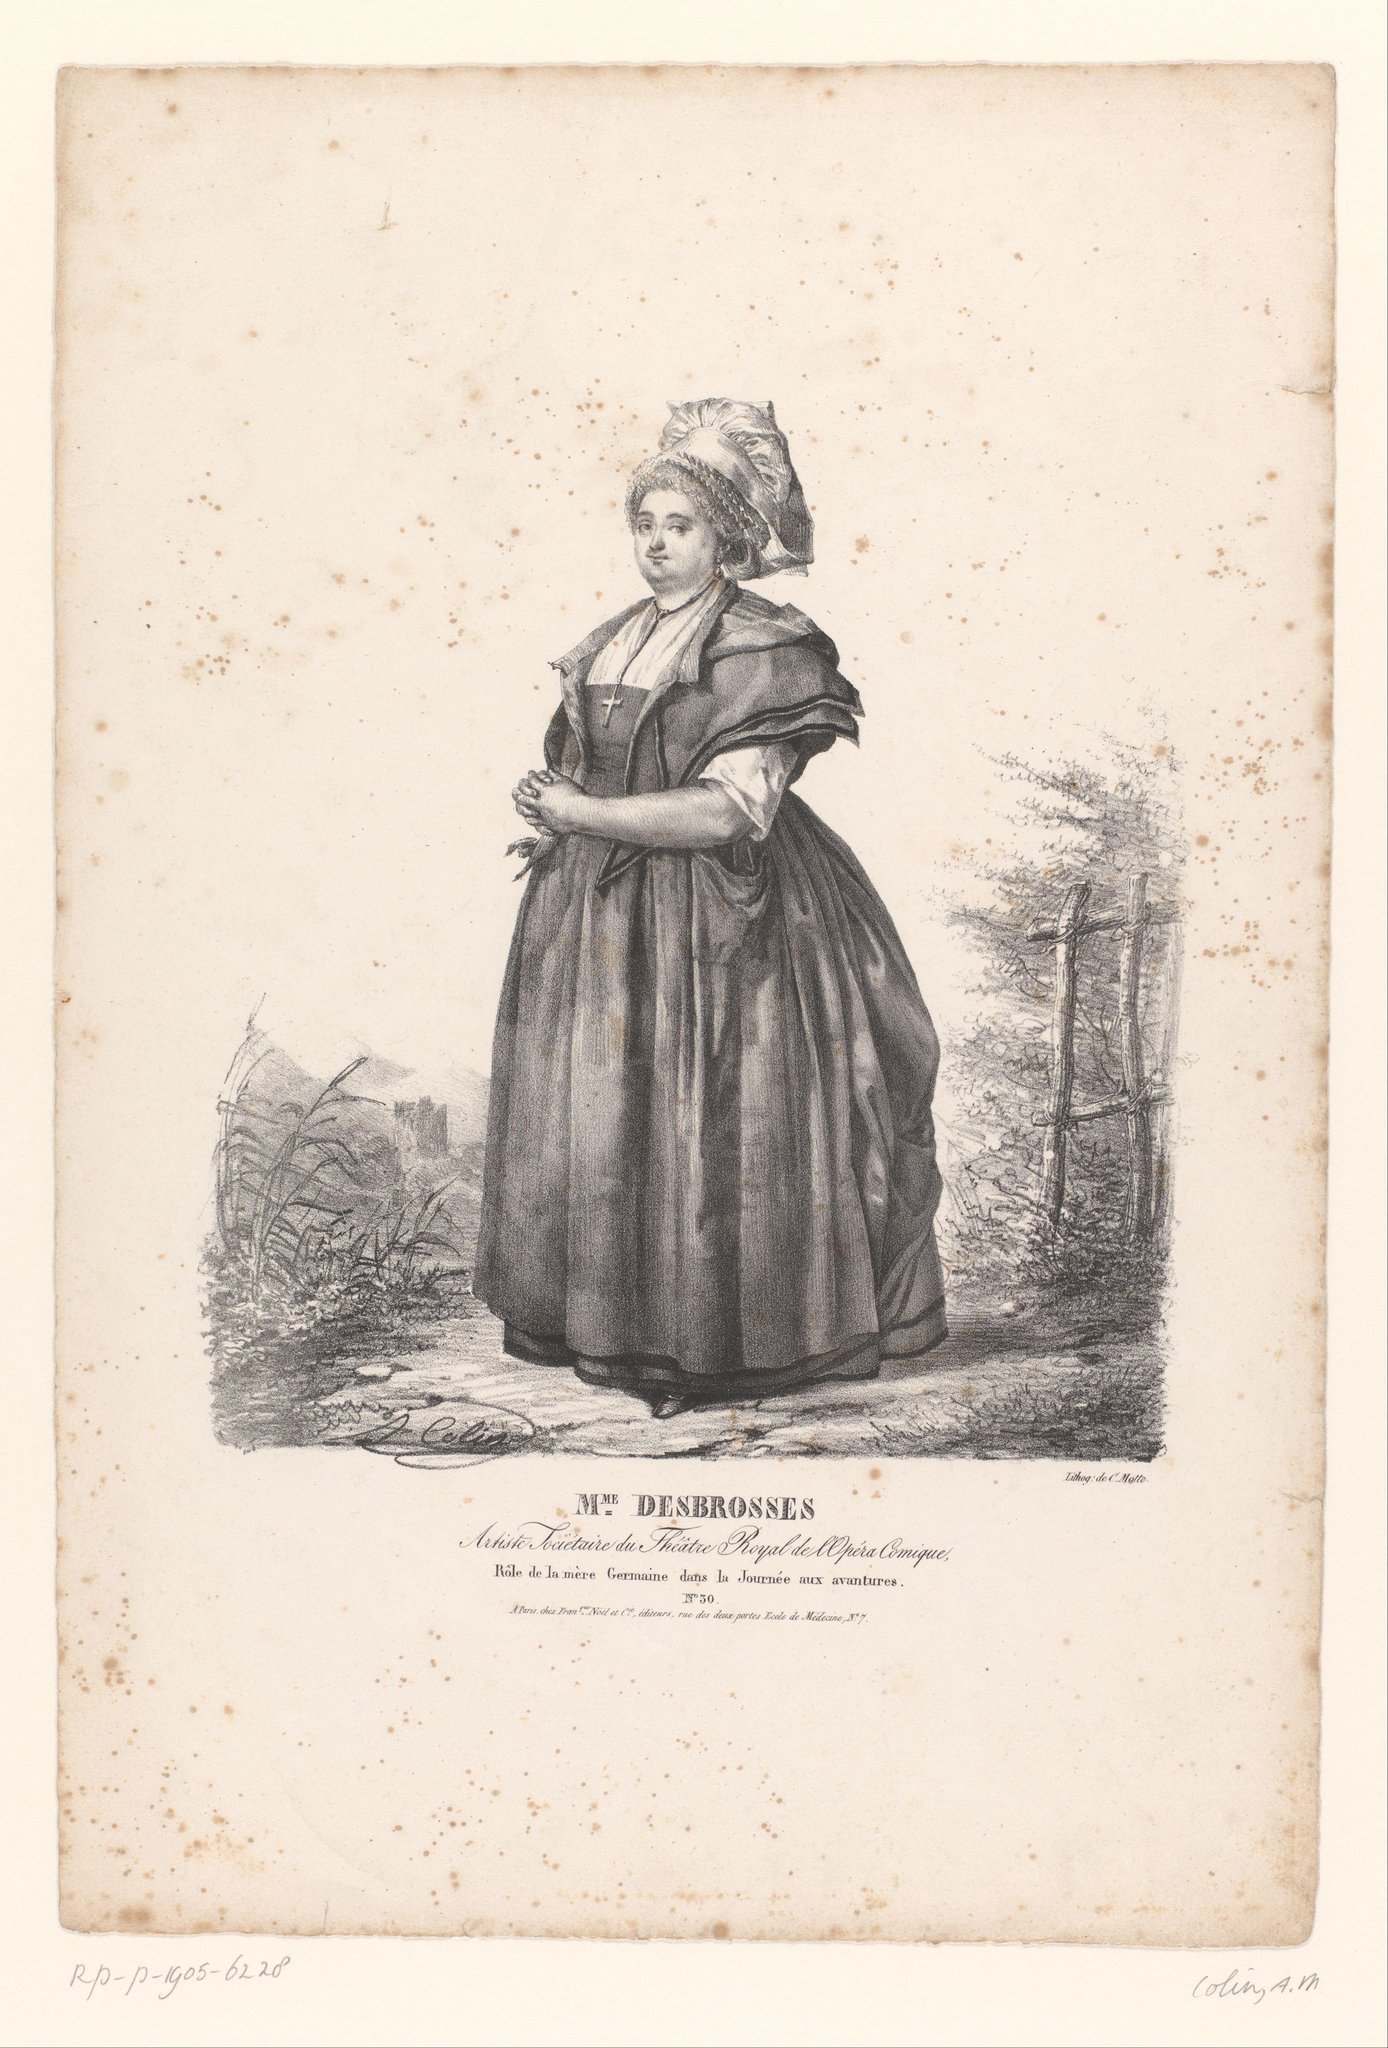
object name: print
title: Portret van Marie Desbrosses als Germaine in de opera La journée aux aventures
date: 1823-1824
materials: paper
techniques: lithograph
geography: paris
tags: stage costume, portrait of actor, actress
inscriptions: collector's mark: Lugt 2228a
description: Germaine is een personage uit de opéra-comique 'La Journée aux Aventures' (librettisten: Pierre-David-Augustin Chapelle en Louis Mezières-Miot, componist: Étienne Méhul). Opgevoerd door het Théâtre Royal de l'Opéra Comique in 1816.